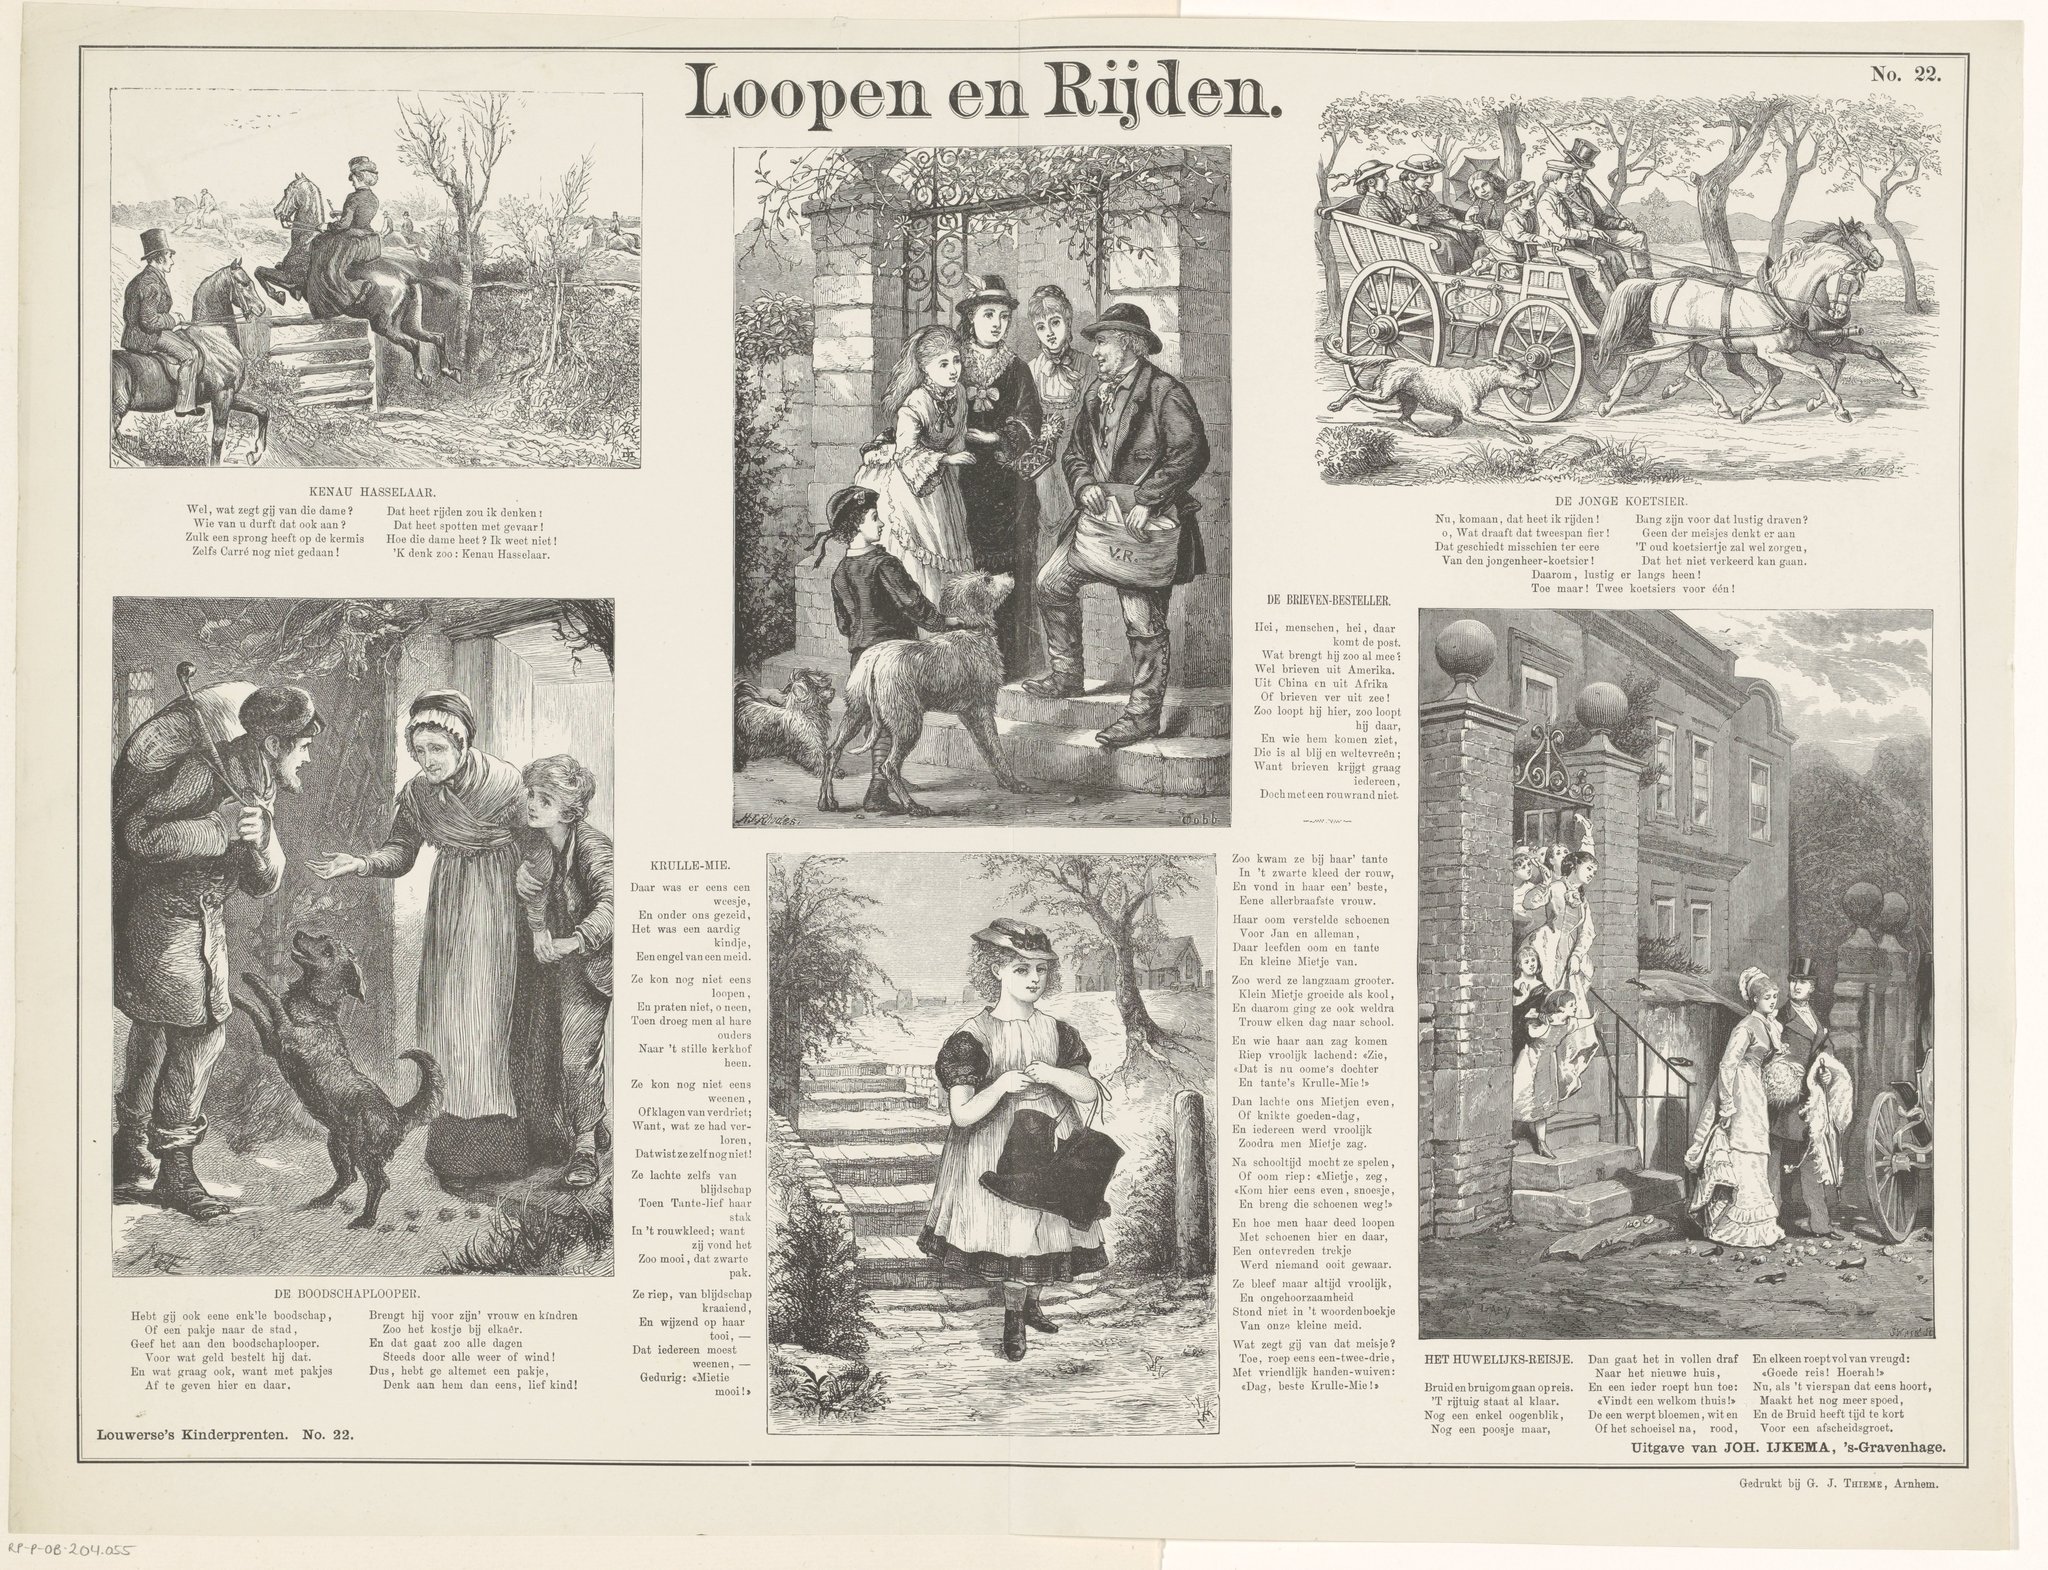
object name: popular print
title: Louwerse's kinderprenten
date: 1882-1905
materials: paper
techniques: letterpress printing, printing block, engraving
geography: arnhem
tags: riding a horse, ass, or mule; rider, horseman, delivering; receiving (~ postal matter), departure (for honeymoon)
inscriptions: collector's mark: Lugt 2760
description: Blad met 6 voorstellingen van verschillende aard, waaronder voorstellingen van een vrouwelijke ruiter te paard, kinderen die een praatje maken met de postbode en een bruidspaar dat vertrekt op huwelijksreis. Tussen de afbeeldingen versjes in boekdruk. Genummerd rechtsboven en linksonder: No. 22.